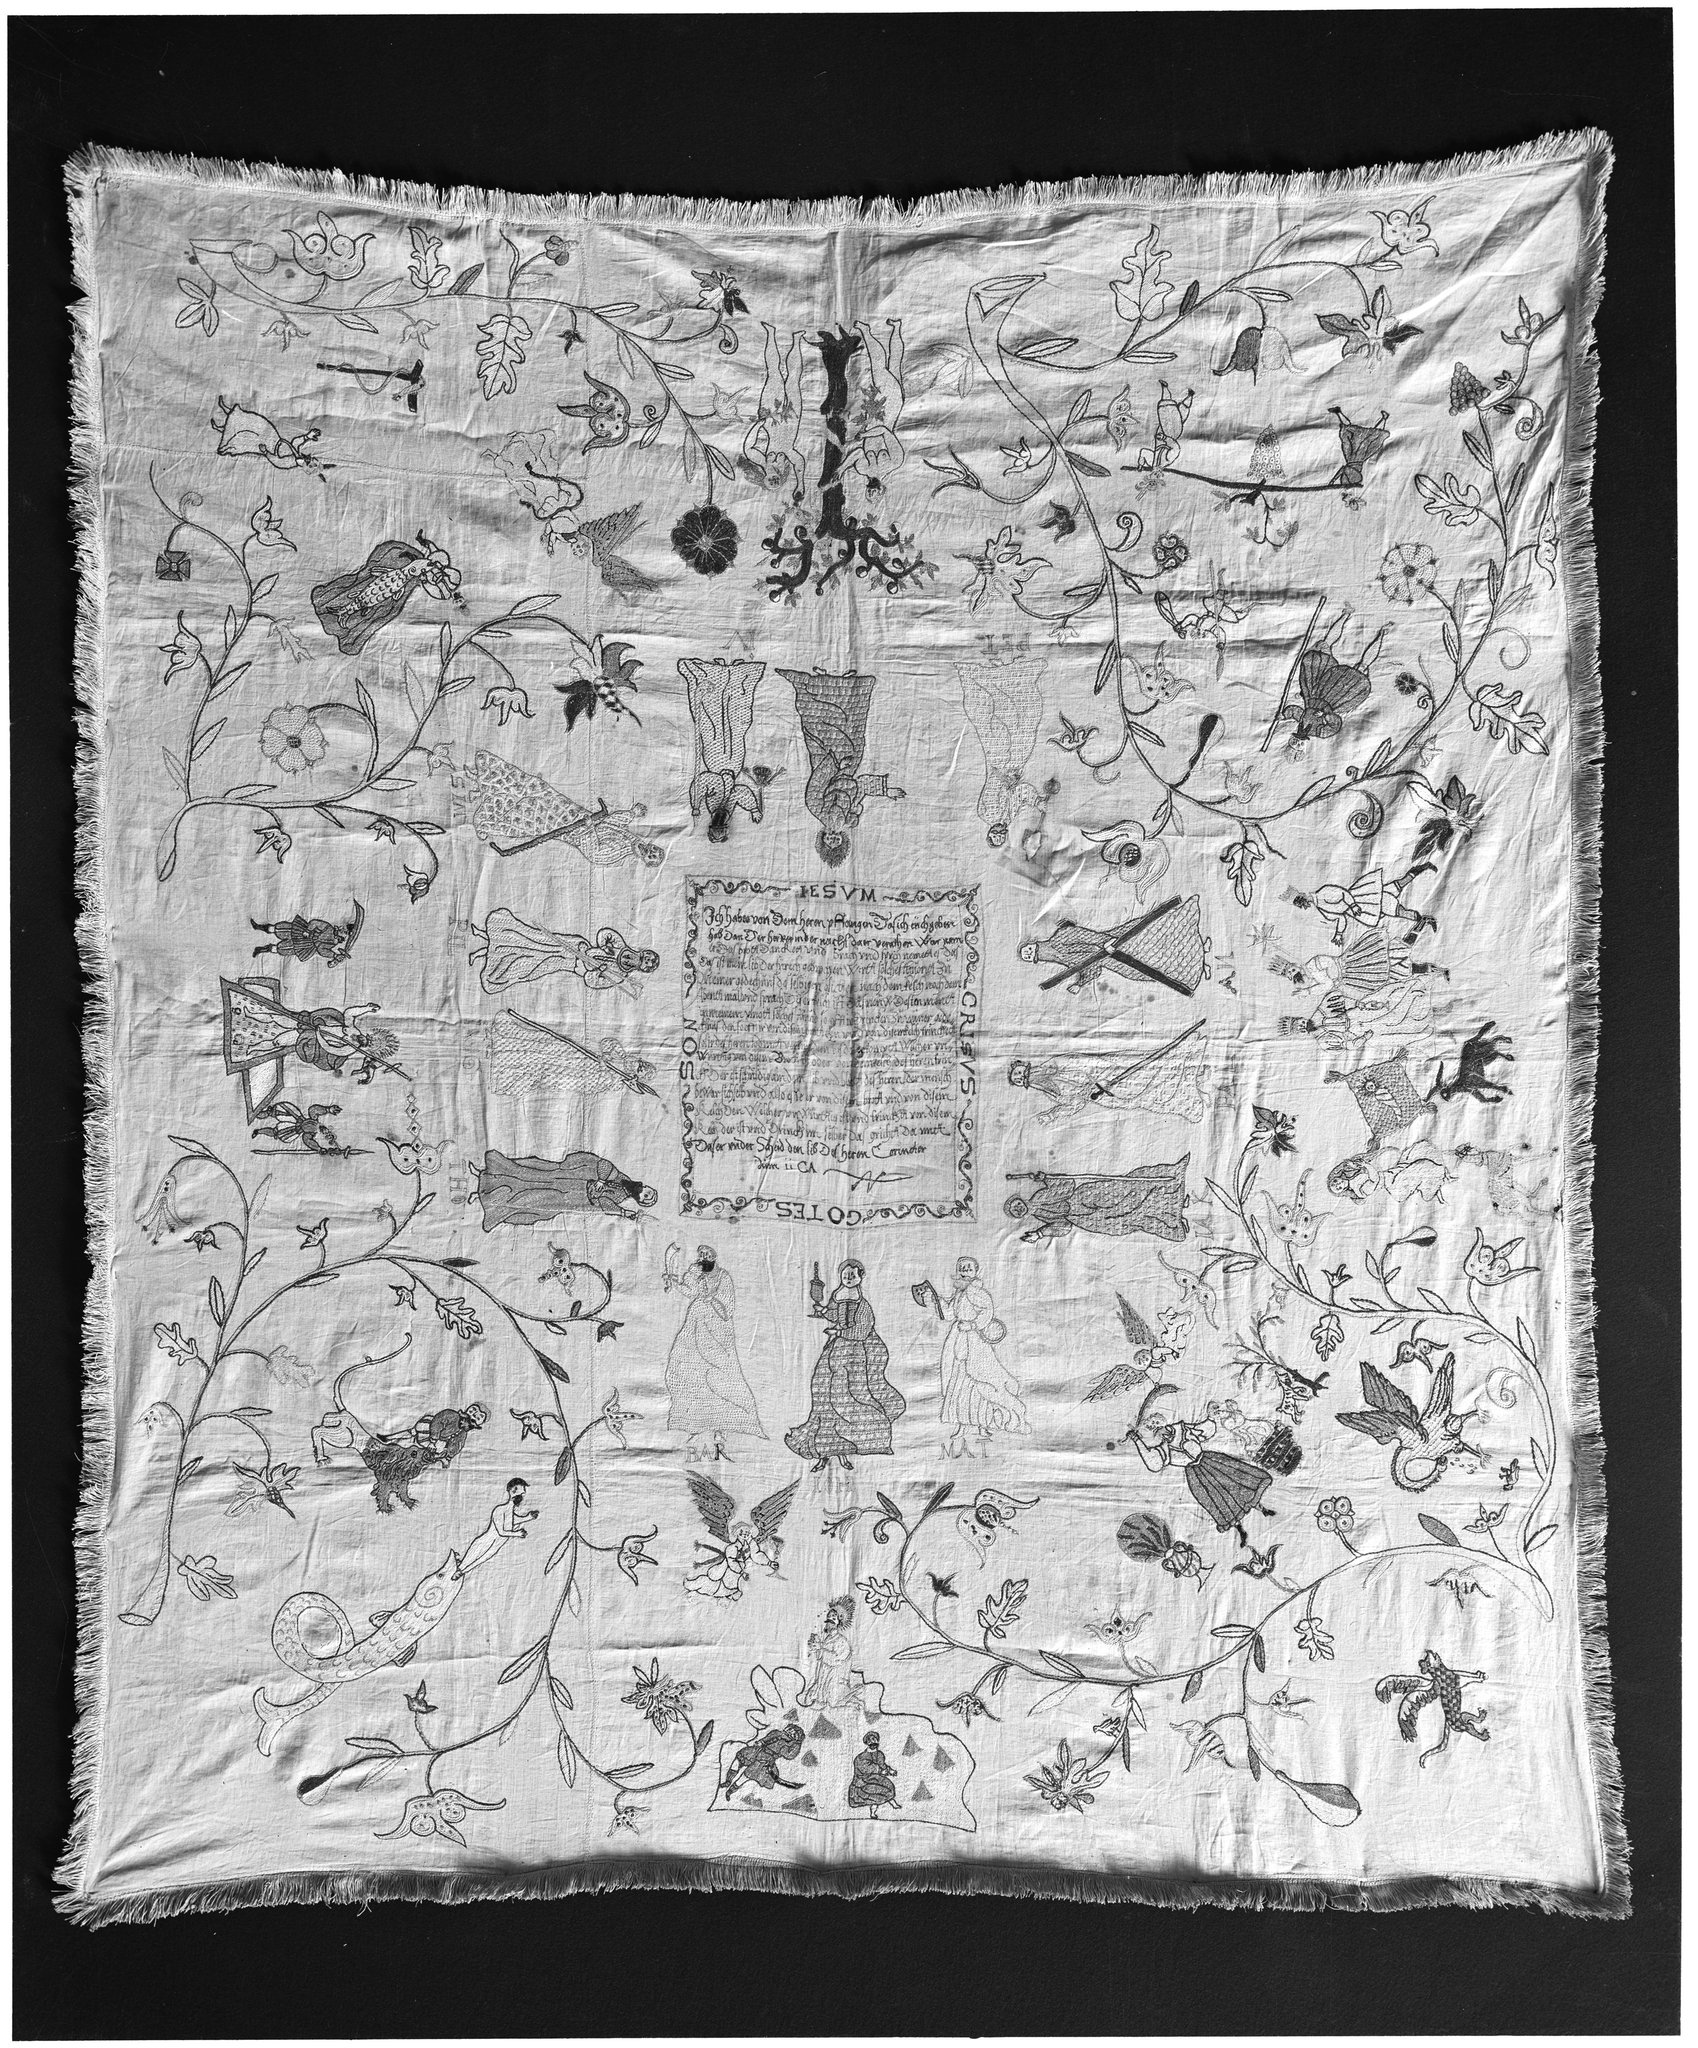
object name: cover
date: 1501-1700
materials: linen, metal thread, silk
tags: animals,men,women,flowers